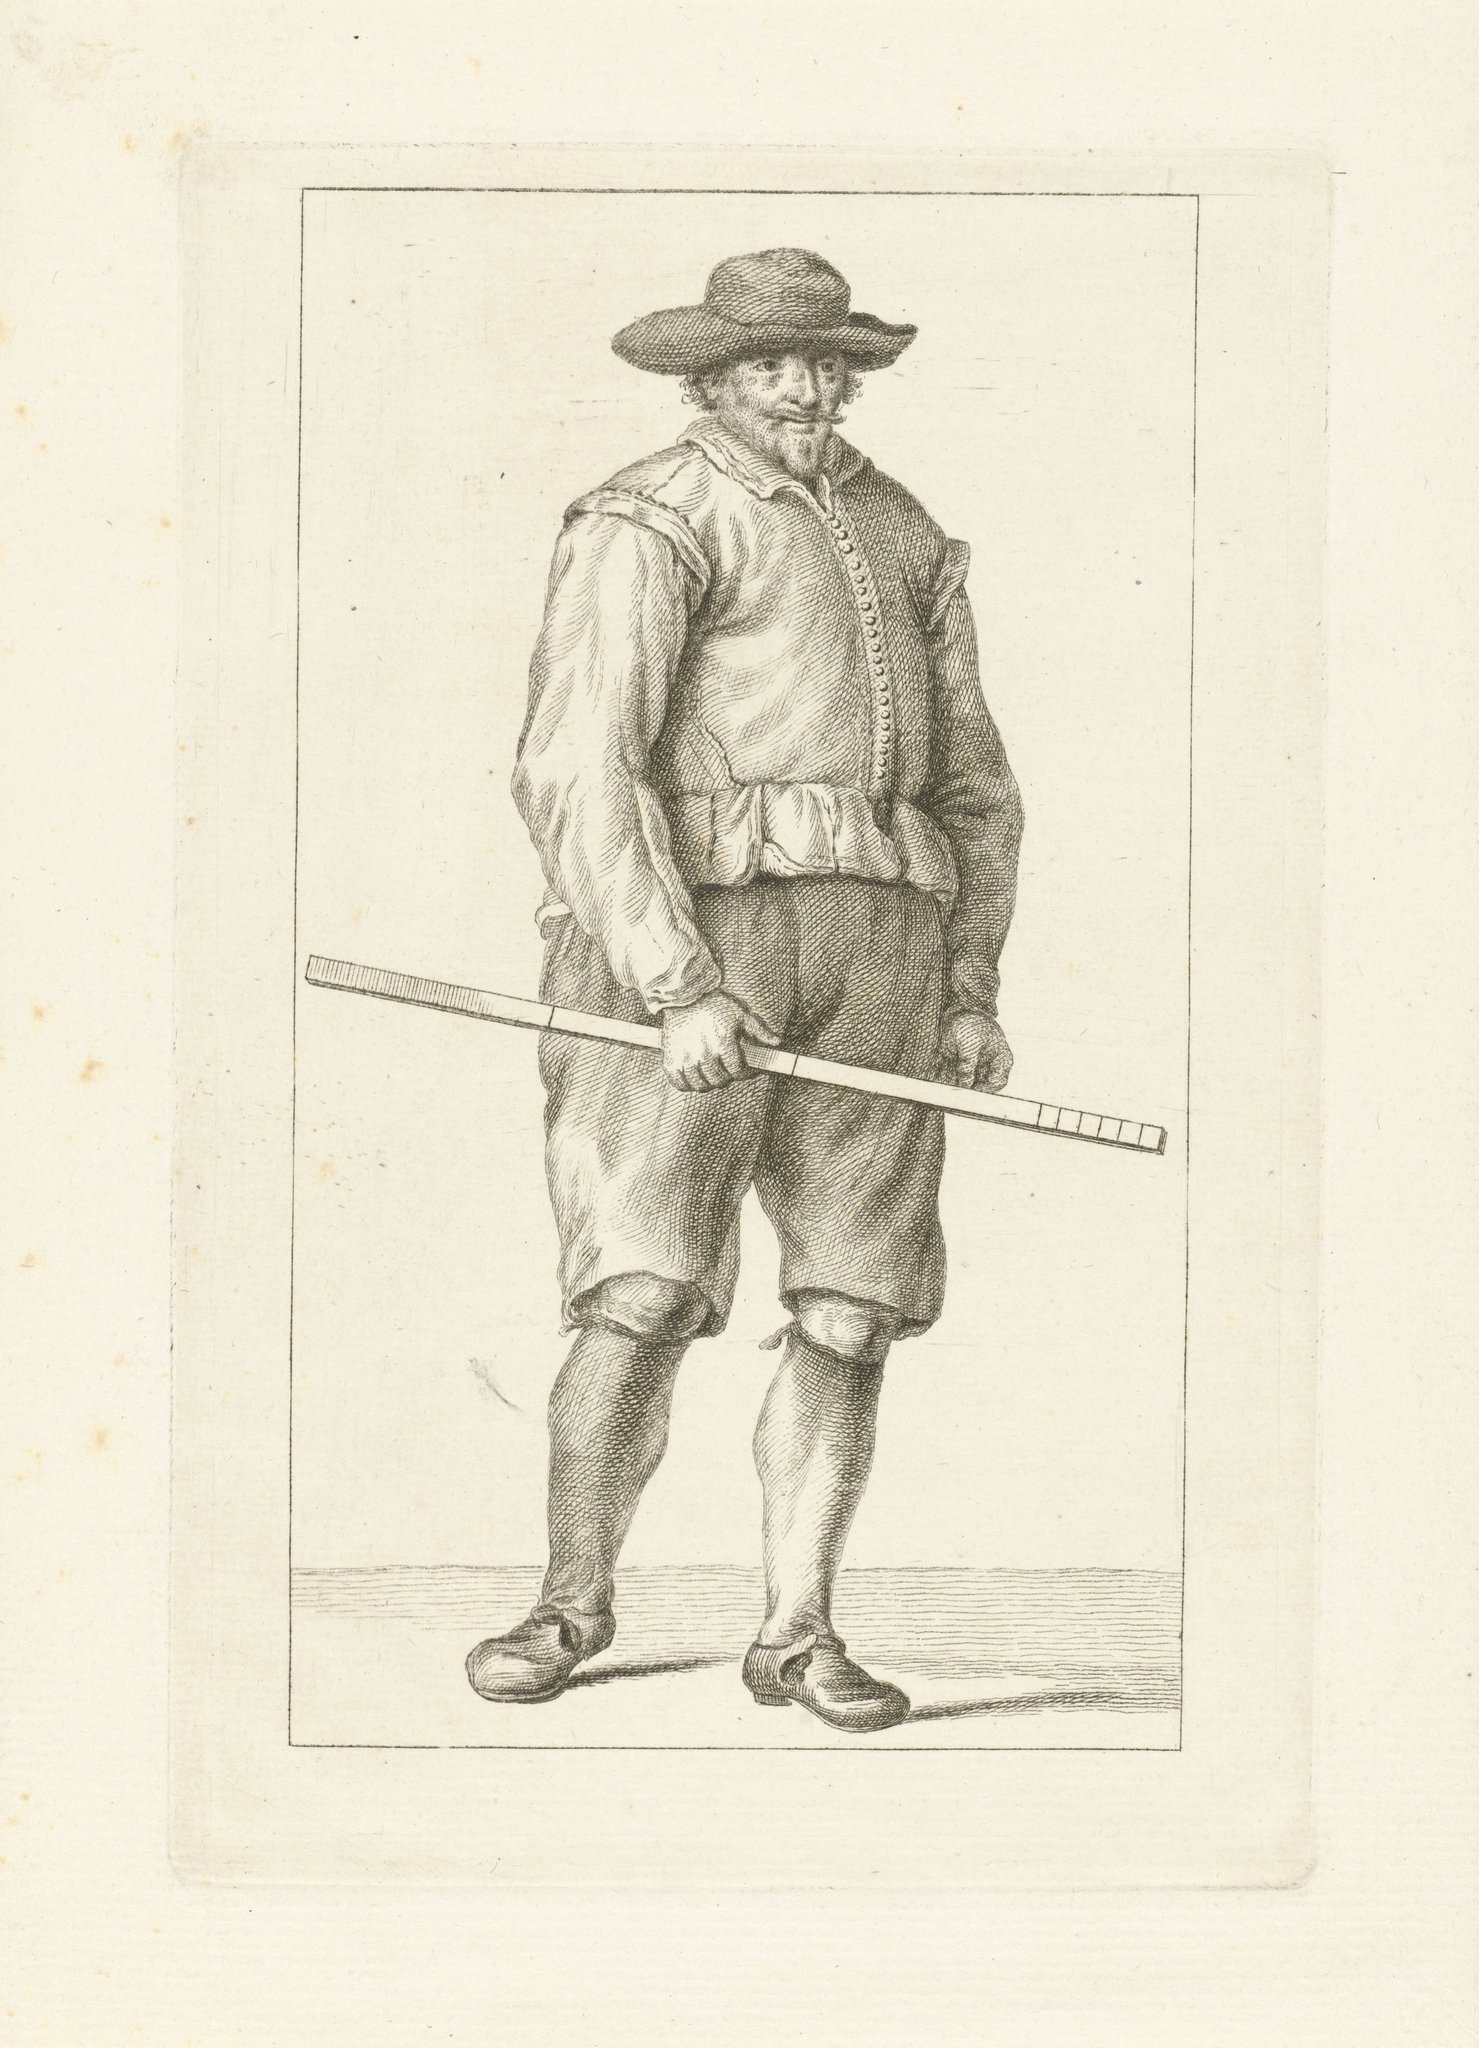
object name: print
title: Hugo de Groot in metselaarskleding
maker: pieter de mare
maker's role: print maker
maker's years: 1758-1796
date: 1791-1793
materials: paper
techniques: engraving, etching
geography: leiden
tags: delft, hugo de groot, professional clothes, head-gear: hat (+ men's clothes), trousers, breeches, etc. (breeches) (+ men's clothes), clothing for the upper part of the body (doublet) (+ men's clothes)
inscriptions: collector's mark: Lugt 2233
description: Prent ook gebruikt in: Afbeelding van Hugo de Groot, in het gewaad van een' metzelaar ... benevens eene bijzondere afbeelding en beschrijving van het wambuisje, bij die gelegenheid gedraagen. Leiden: P.H. Trap, 1793. Coll. Franken